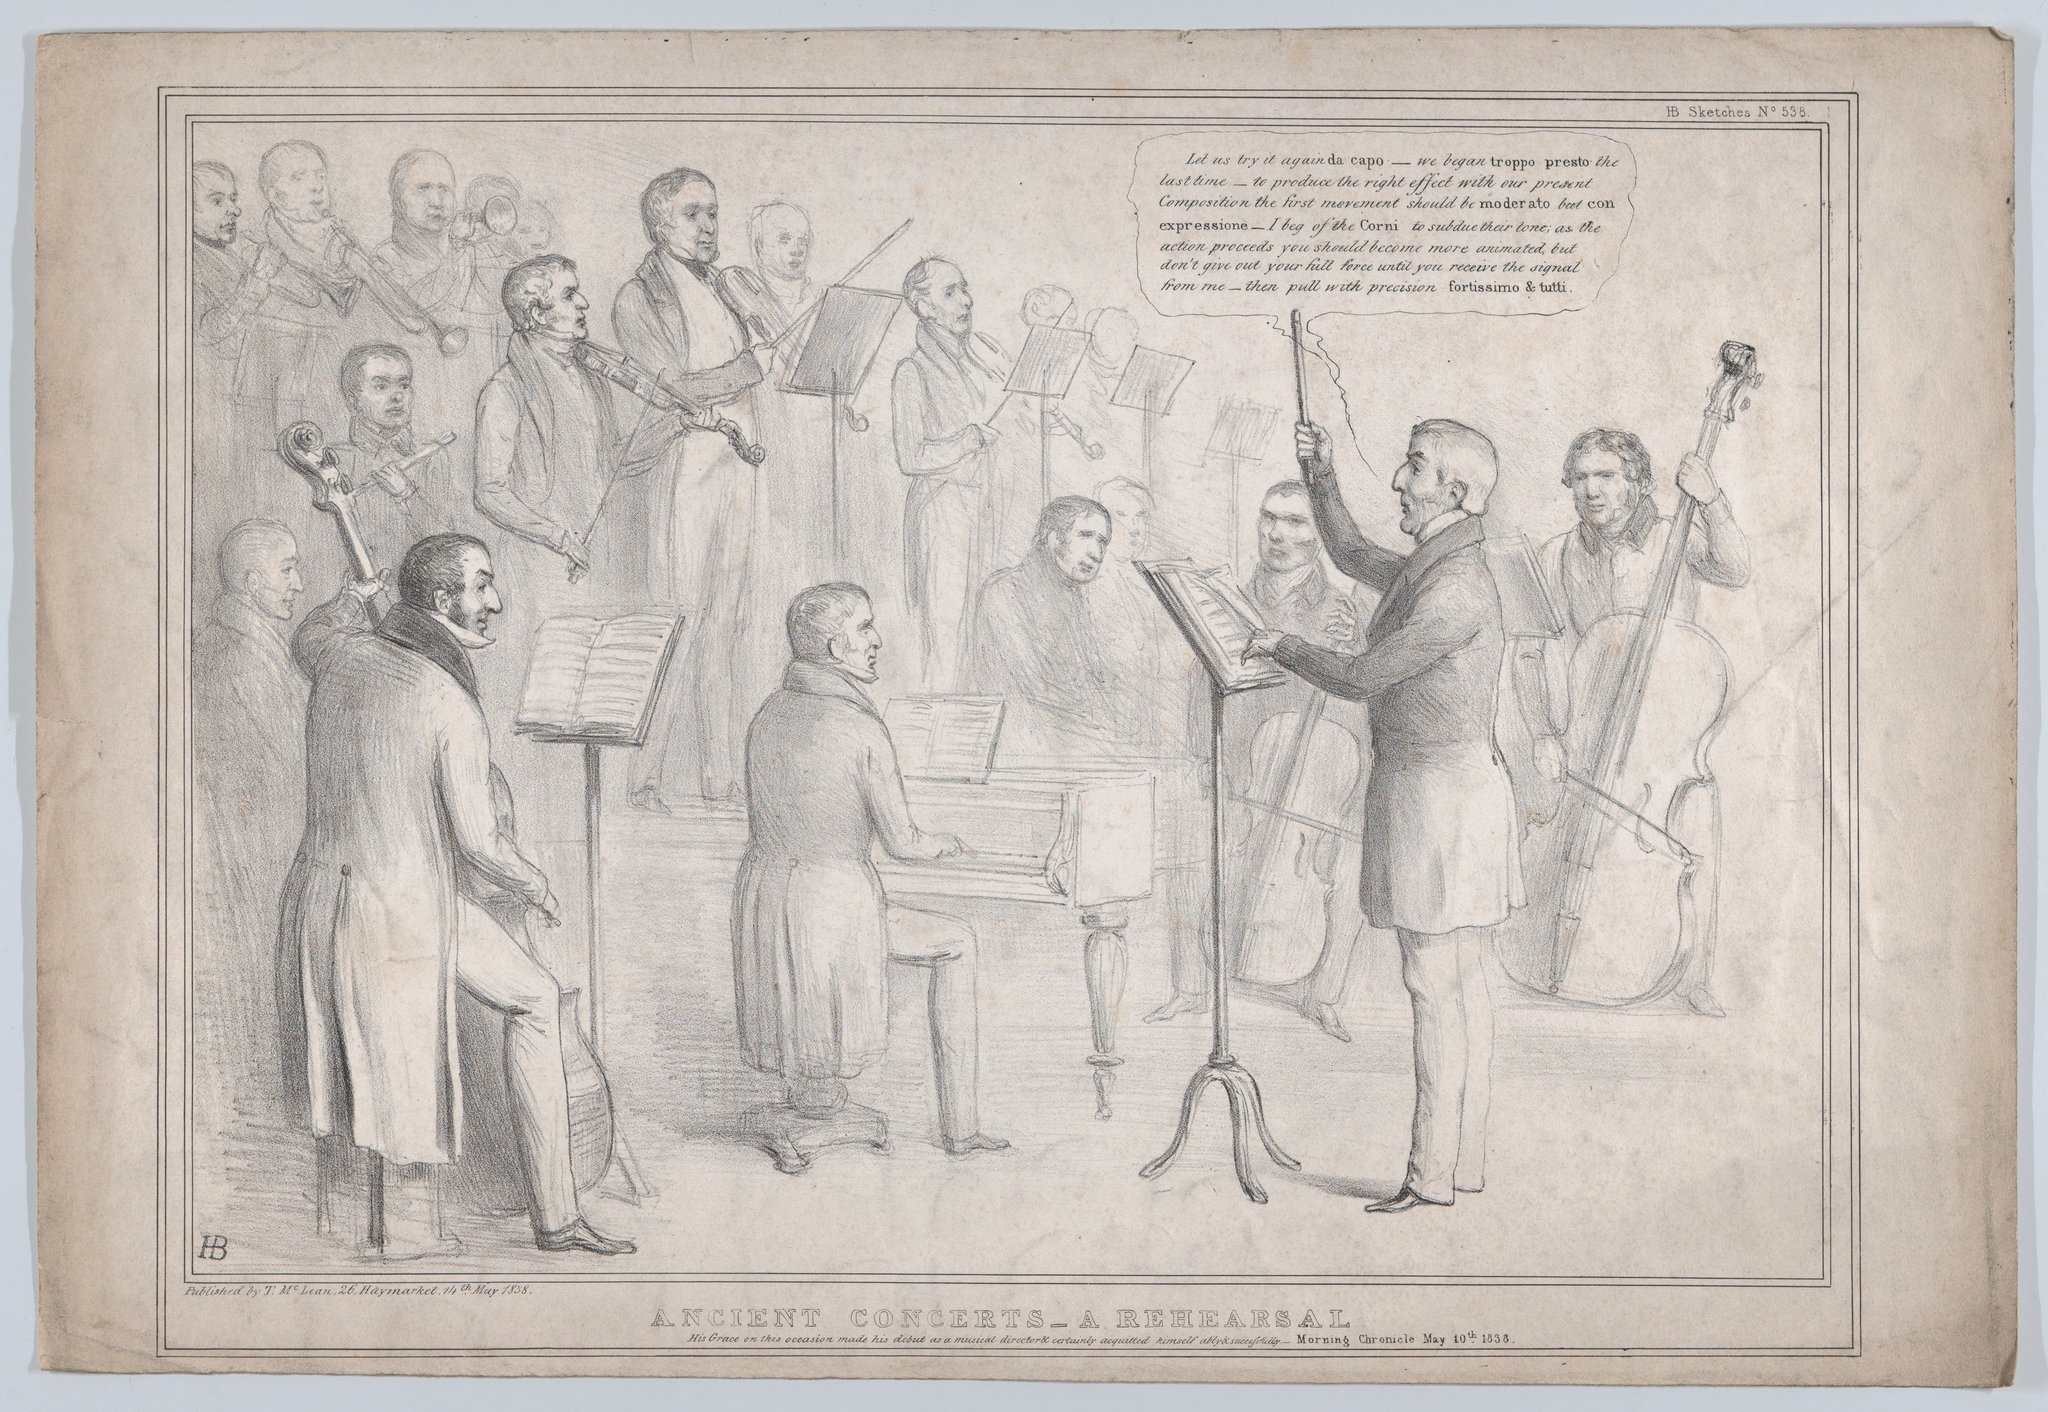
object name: print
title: Ancient Concerts – A Rehearsal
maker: john doyle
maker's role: artist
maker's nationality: irish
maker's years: 1797-1868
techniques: lithograph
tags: musical instruments,men,concerts,musicians